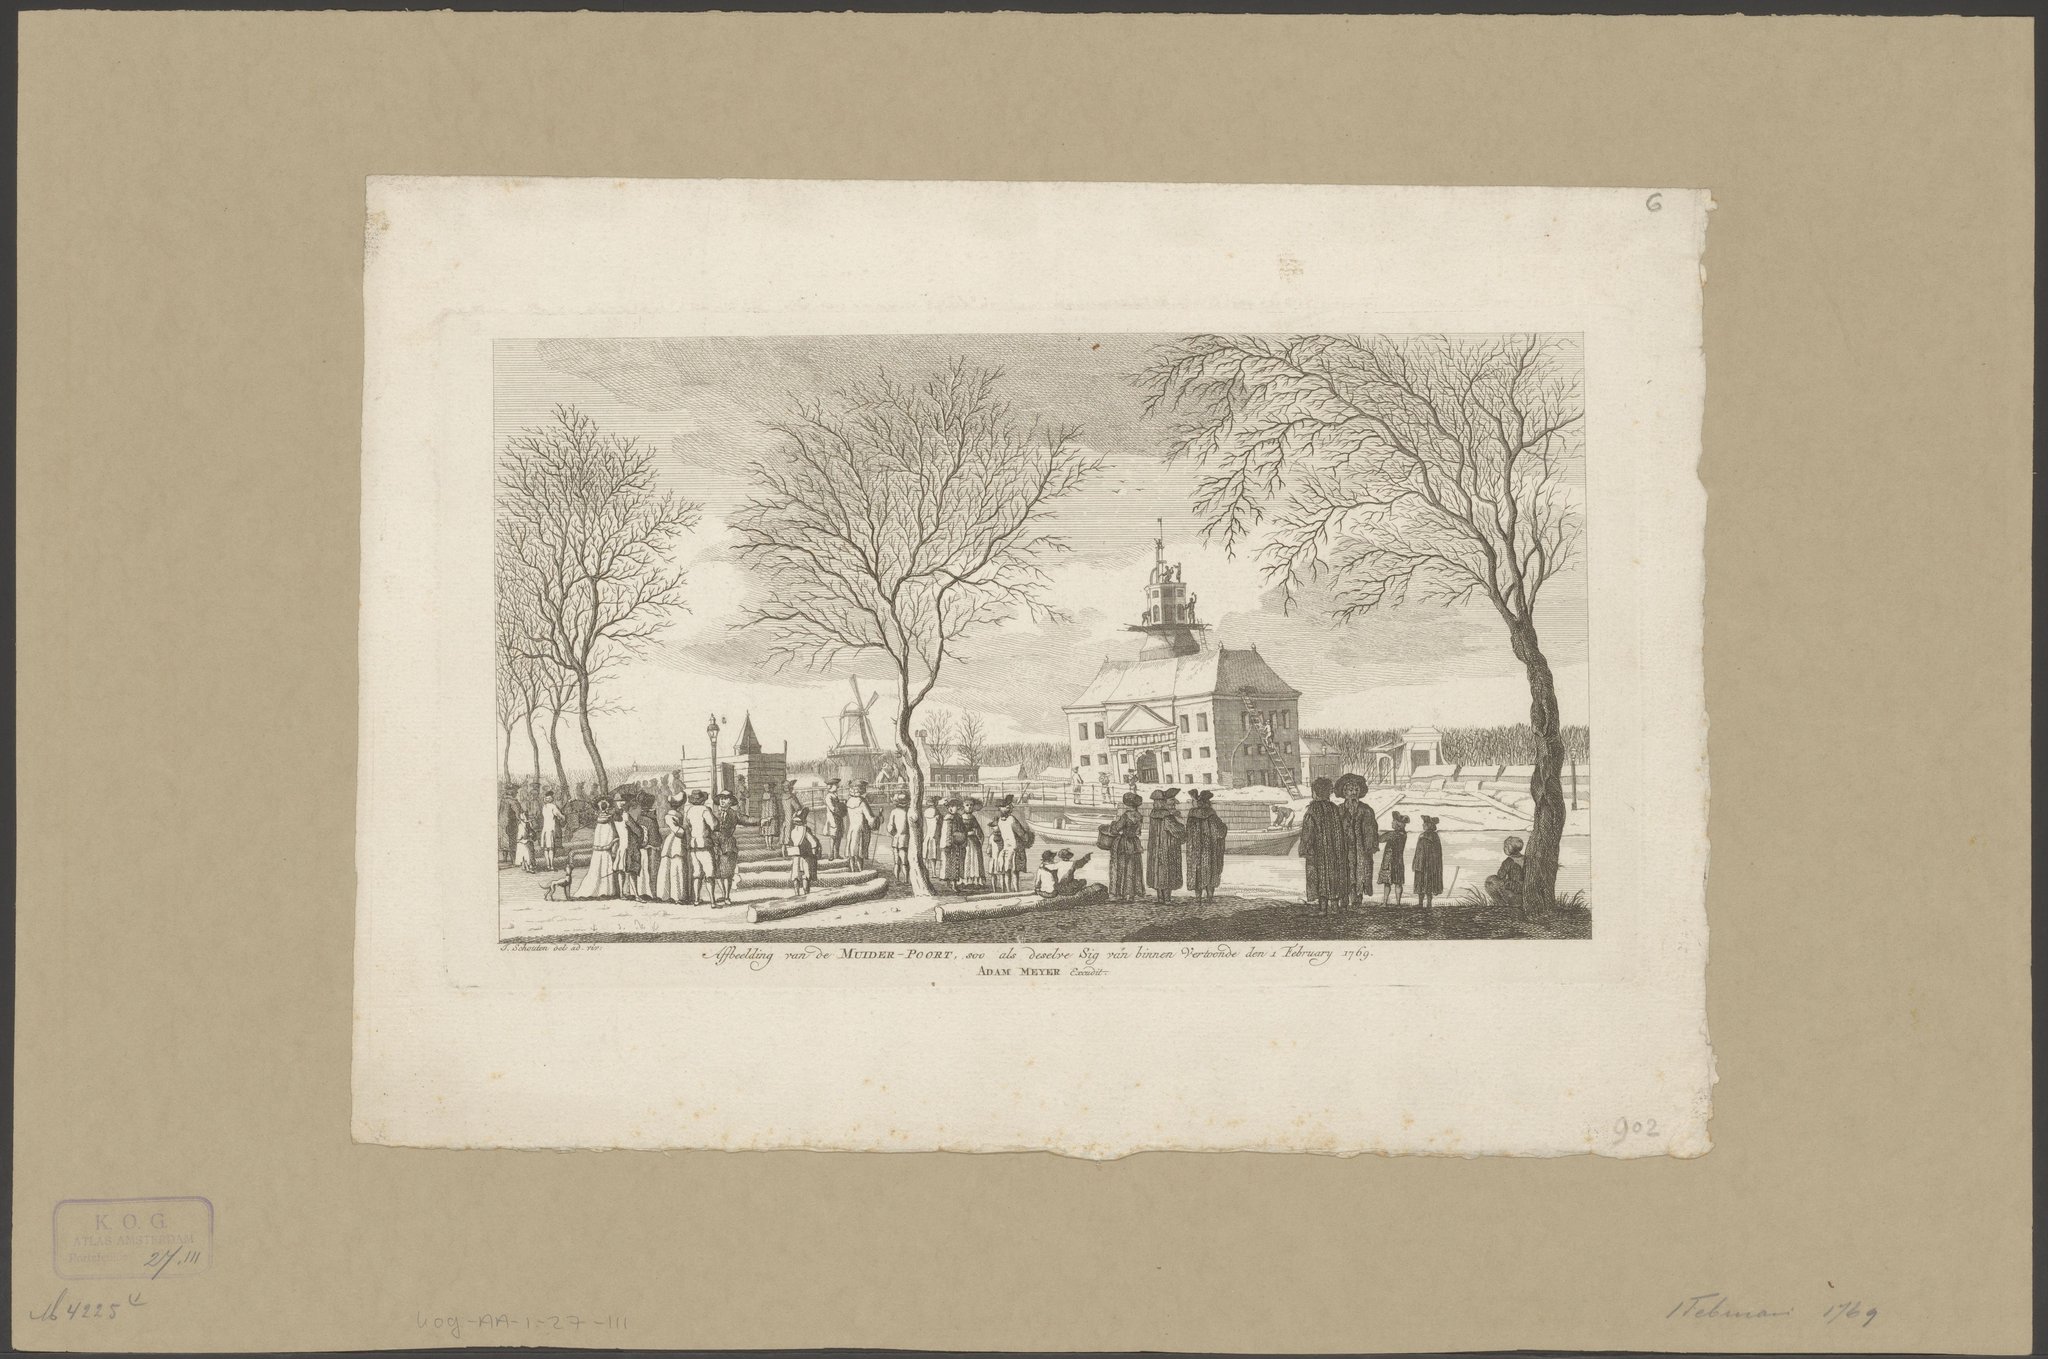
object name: print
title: Sloop van de verzakte Muiderpoort, gezien vanaf de Plantage, 1769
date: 1769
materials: paper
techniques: engraving, etching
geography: amsterdam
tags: city-gate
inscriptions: collector's mark: Lugt 1641b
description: Sloop van de verzakte Muiderpoort te Amsterdam, gezien vanaf de Plantage. Op de voorgrond volgen toeschouwers het begin van de sloopwerkzaamheden, 1 februari 1769. Onderwerpsrubriek binnen de Atlas Amsterdam: Poorten, verzamelbladen, H. Ingezakte Muiderpoort.